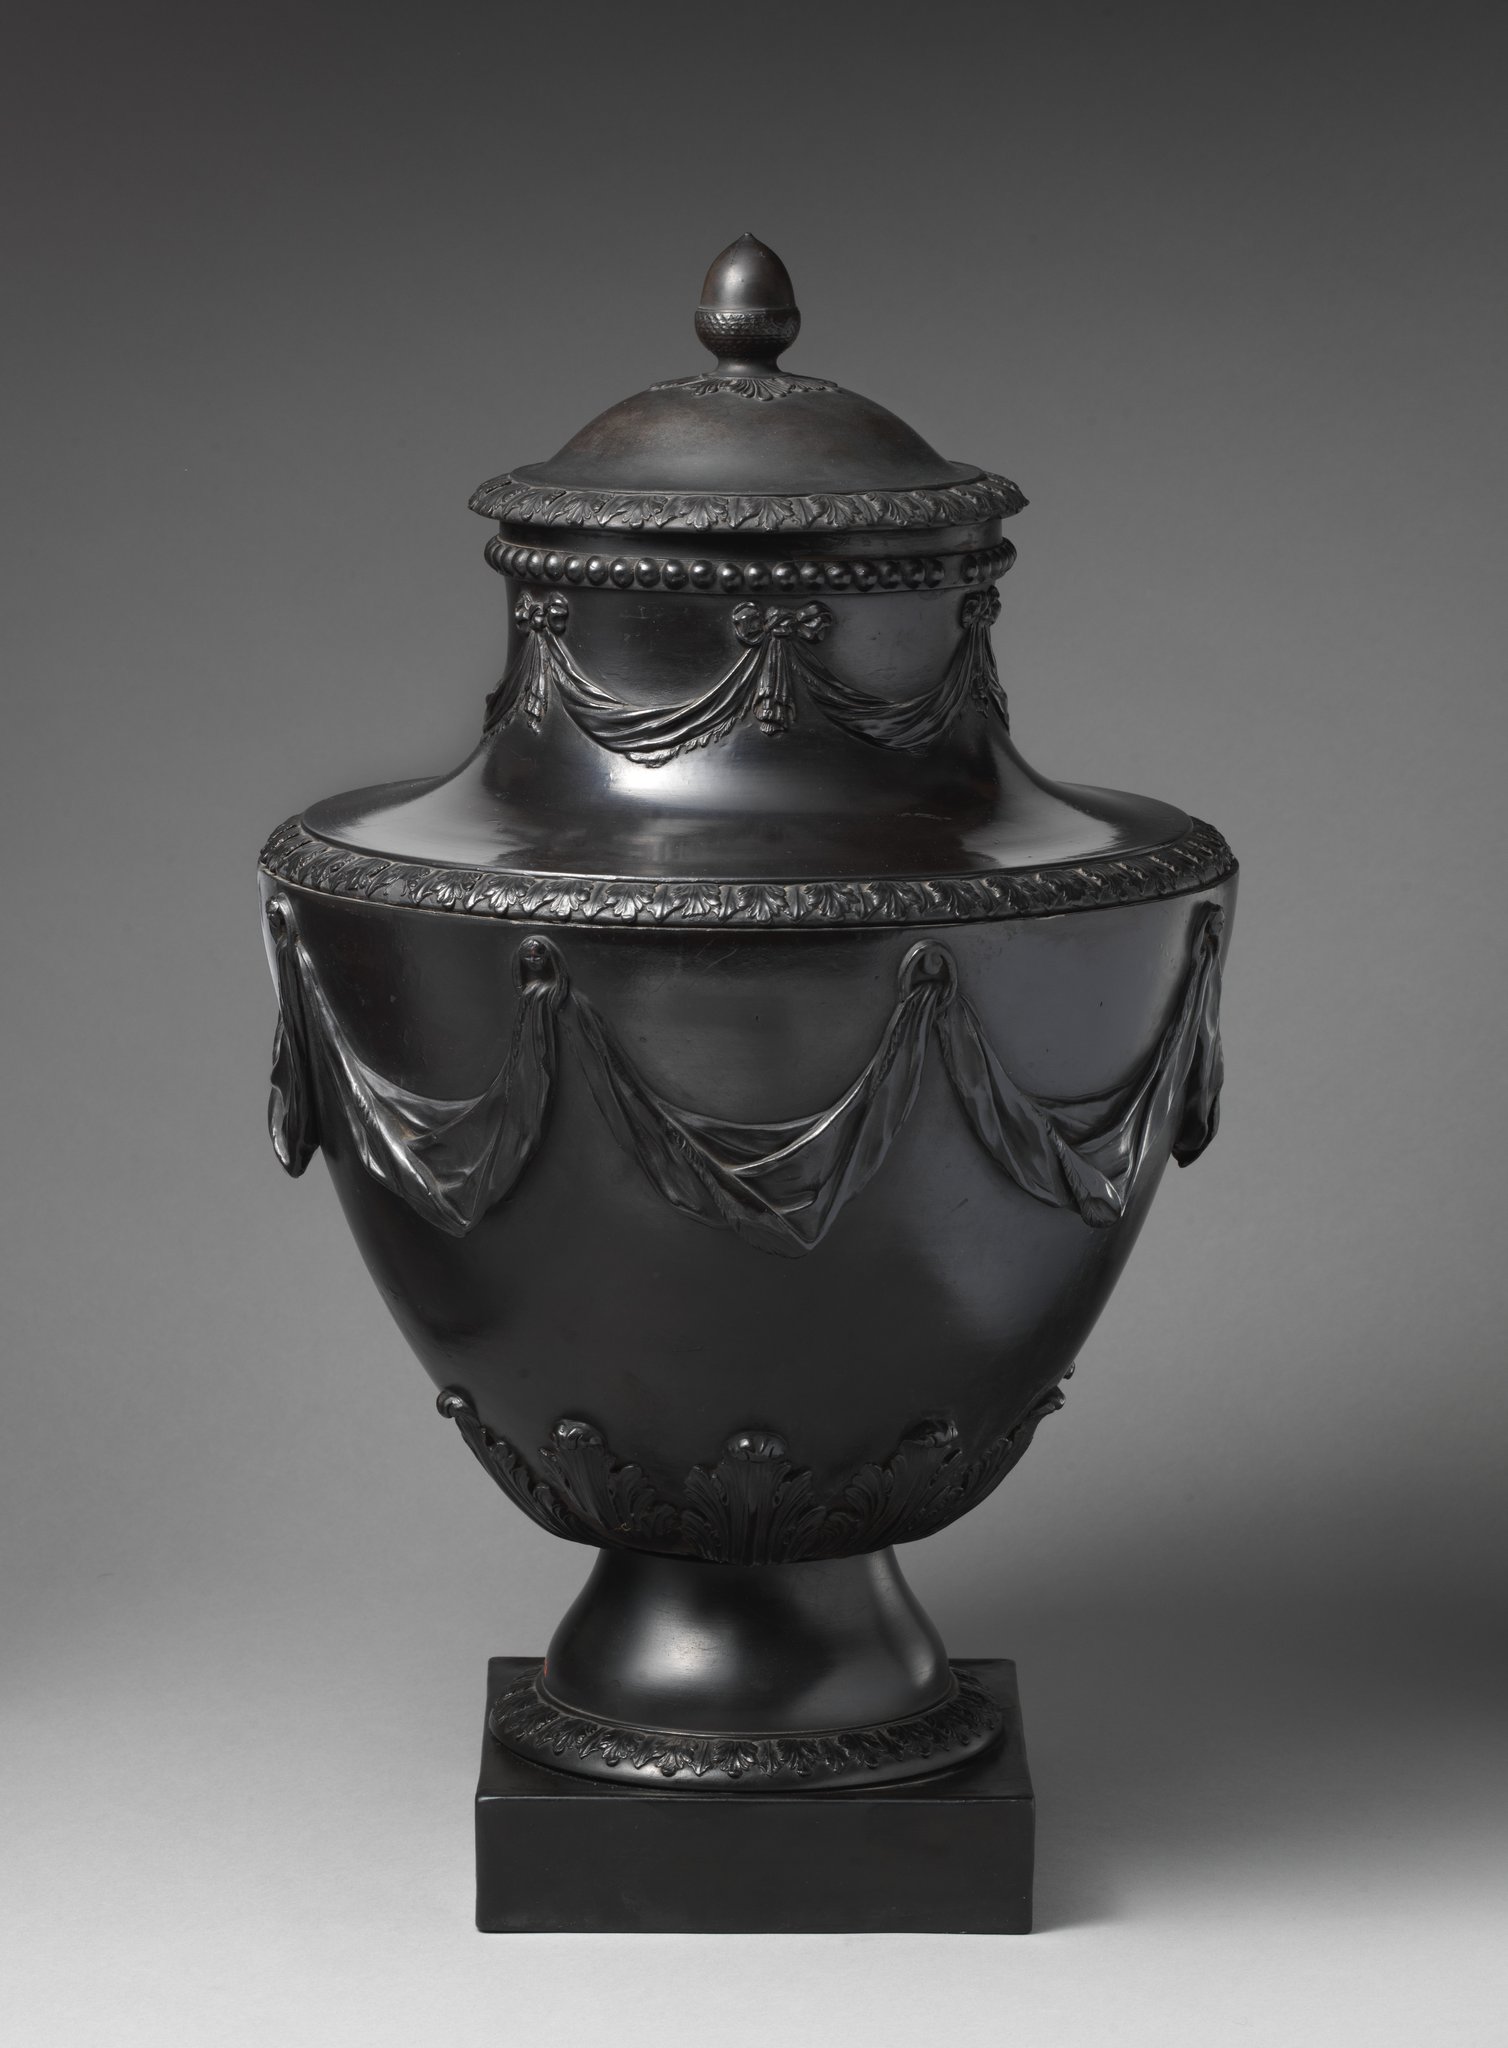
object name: urn with cover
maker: wedgwood and co.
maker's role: manufacturer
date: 1780-1790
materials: stone